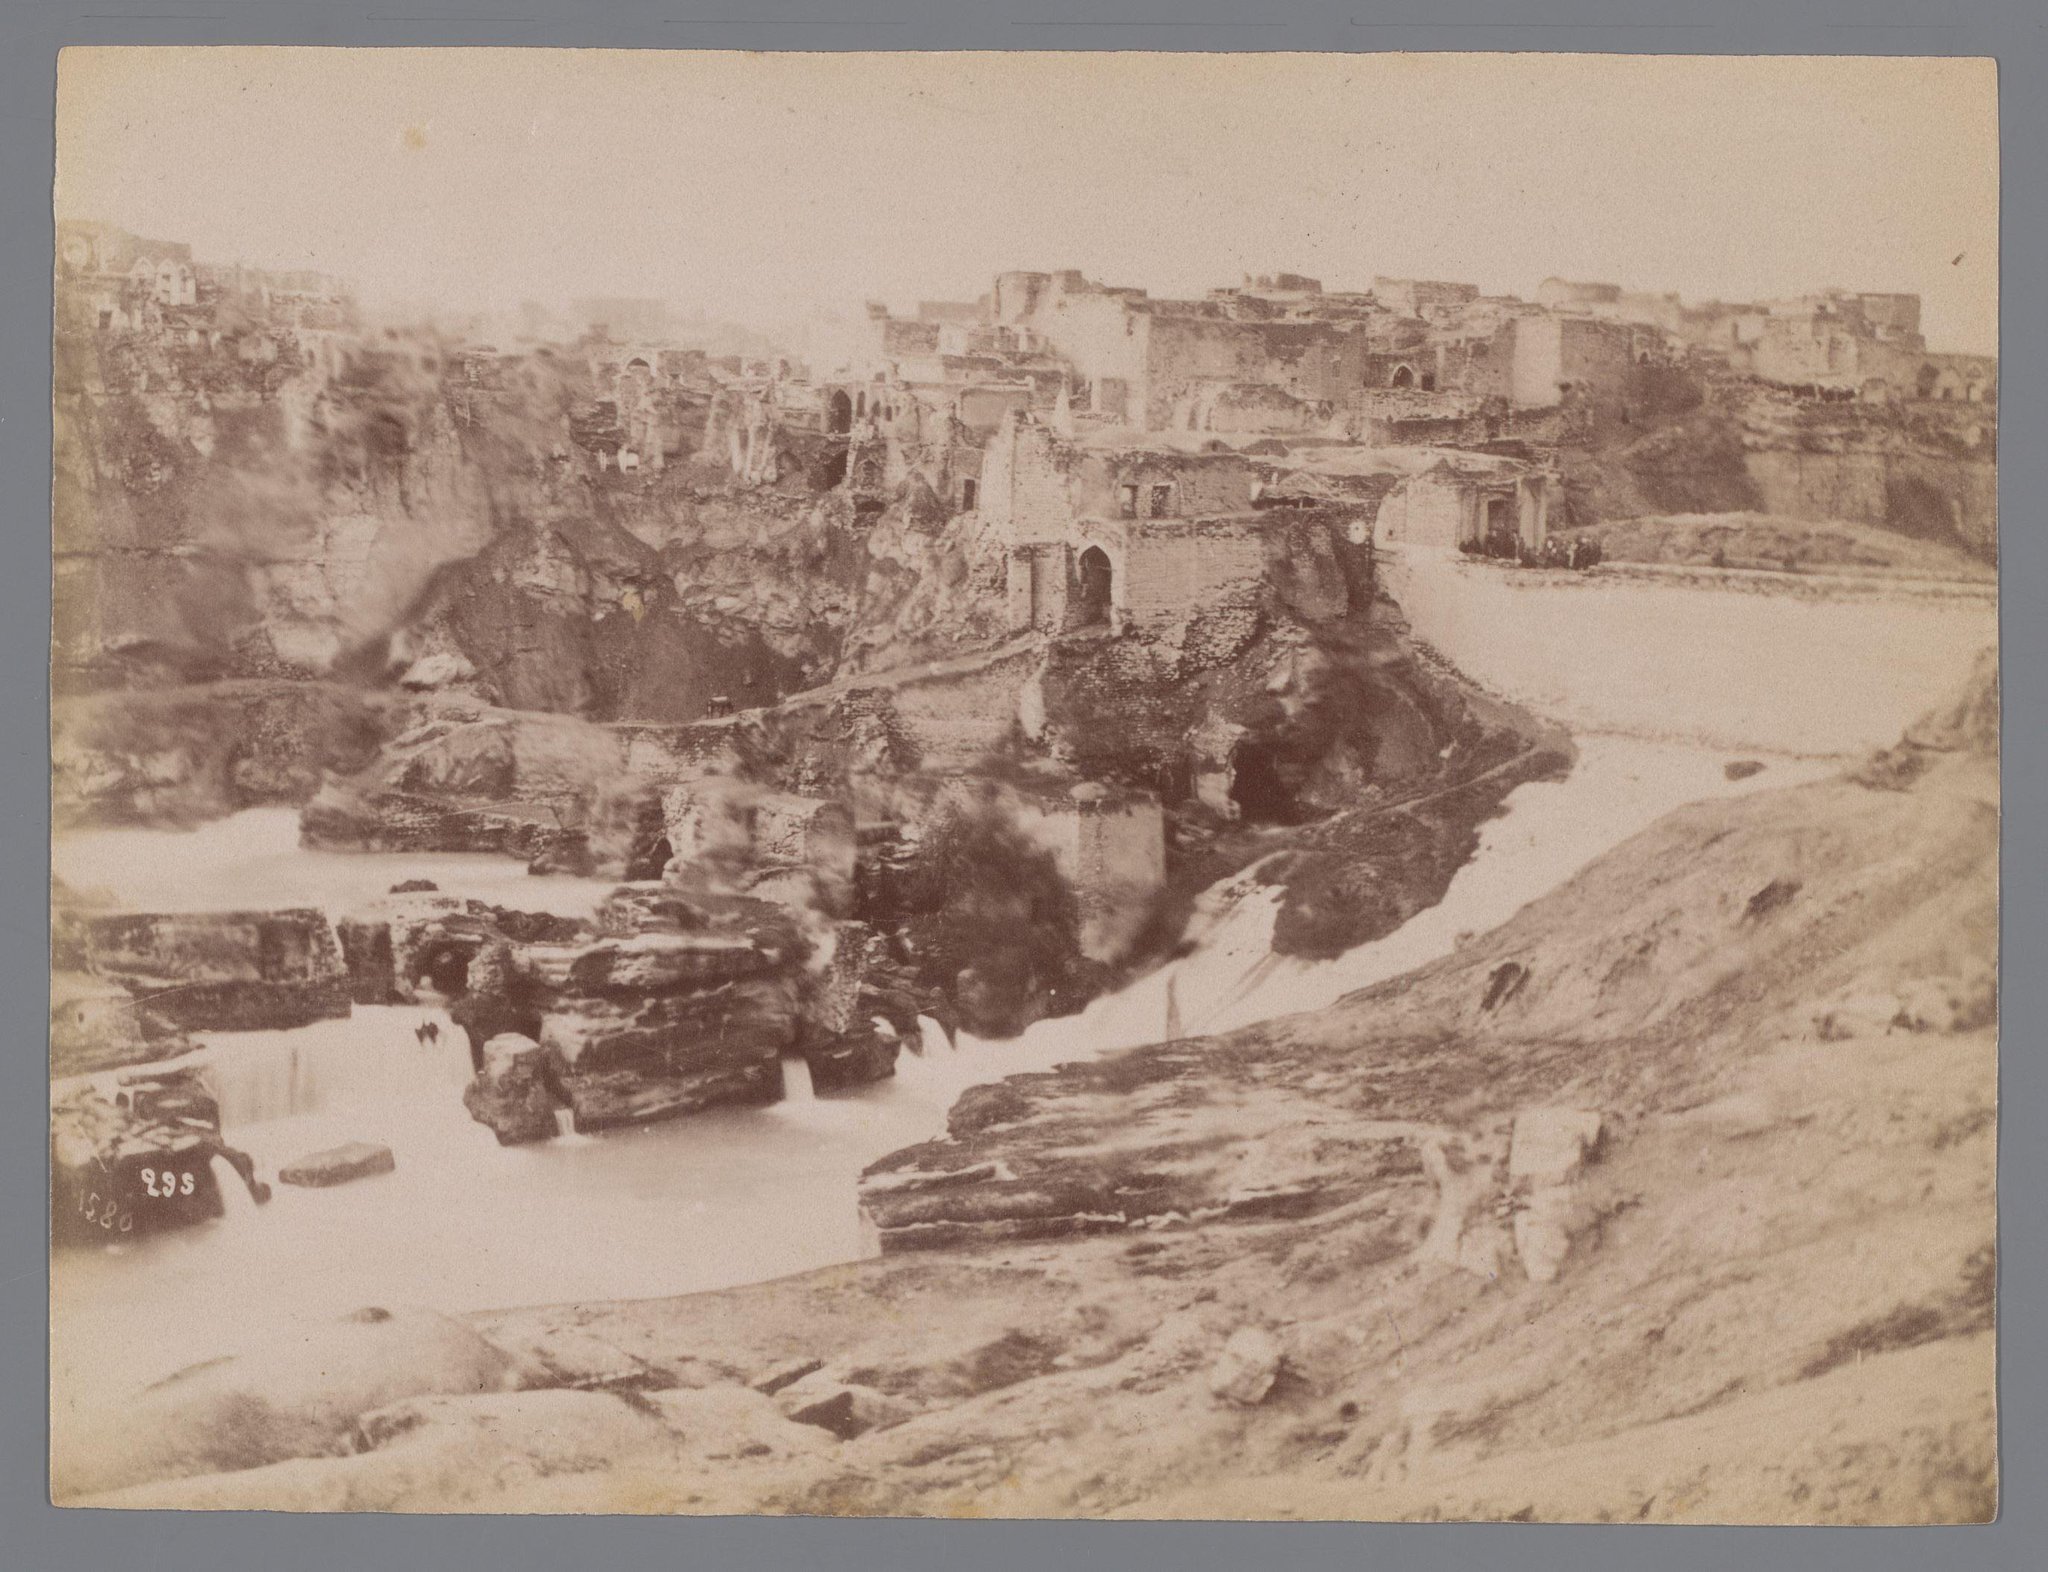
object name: photograph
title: Aanzicht op de stad Shûshtar, Iran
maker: antoine sevruguin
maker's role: fotograaf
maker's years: 1840-1933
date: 1885-1910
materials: paper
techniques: albumen print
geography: iran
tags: iran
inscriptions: number: ‘1580’, number: ‘295’, inscription: ‘Schuster [sic]’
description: Aanzicht op de stad Shûshtar/Shoushtar, Iran. Rotsen en een rivier op de voorgrond, de huizen van de stad zijn op de achtergrond op een rots gelegen.